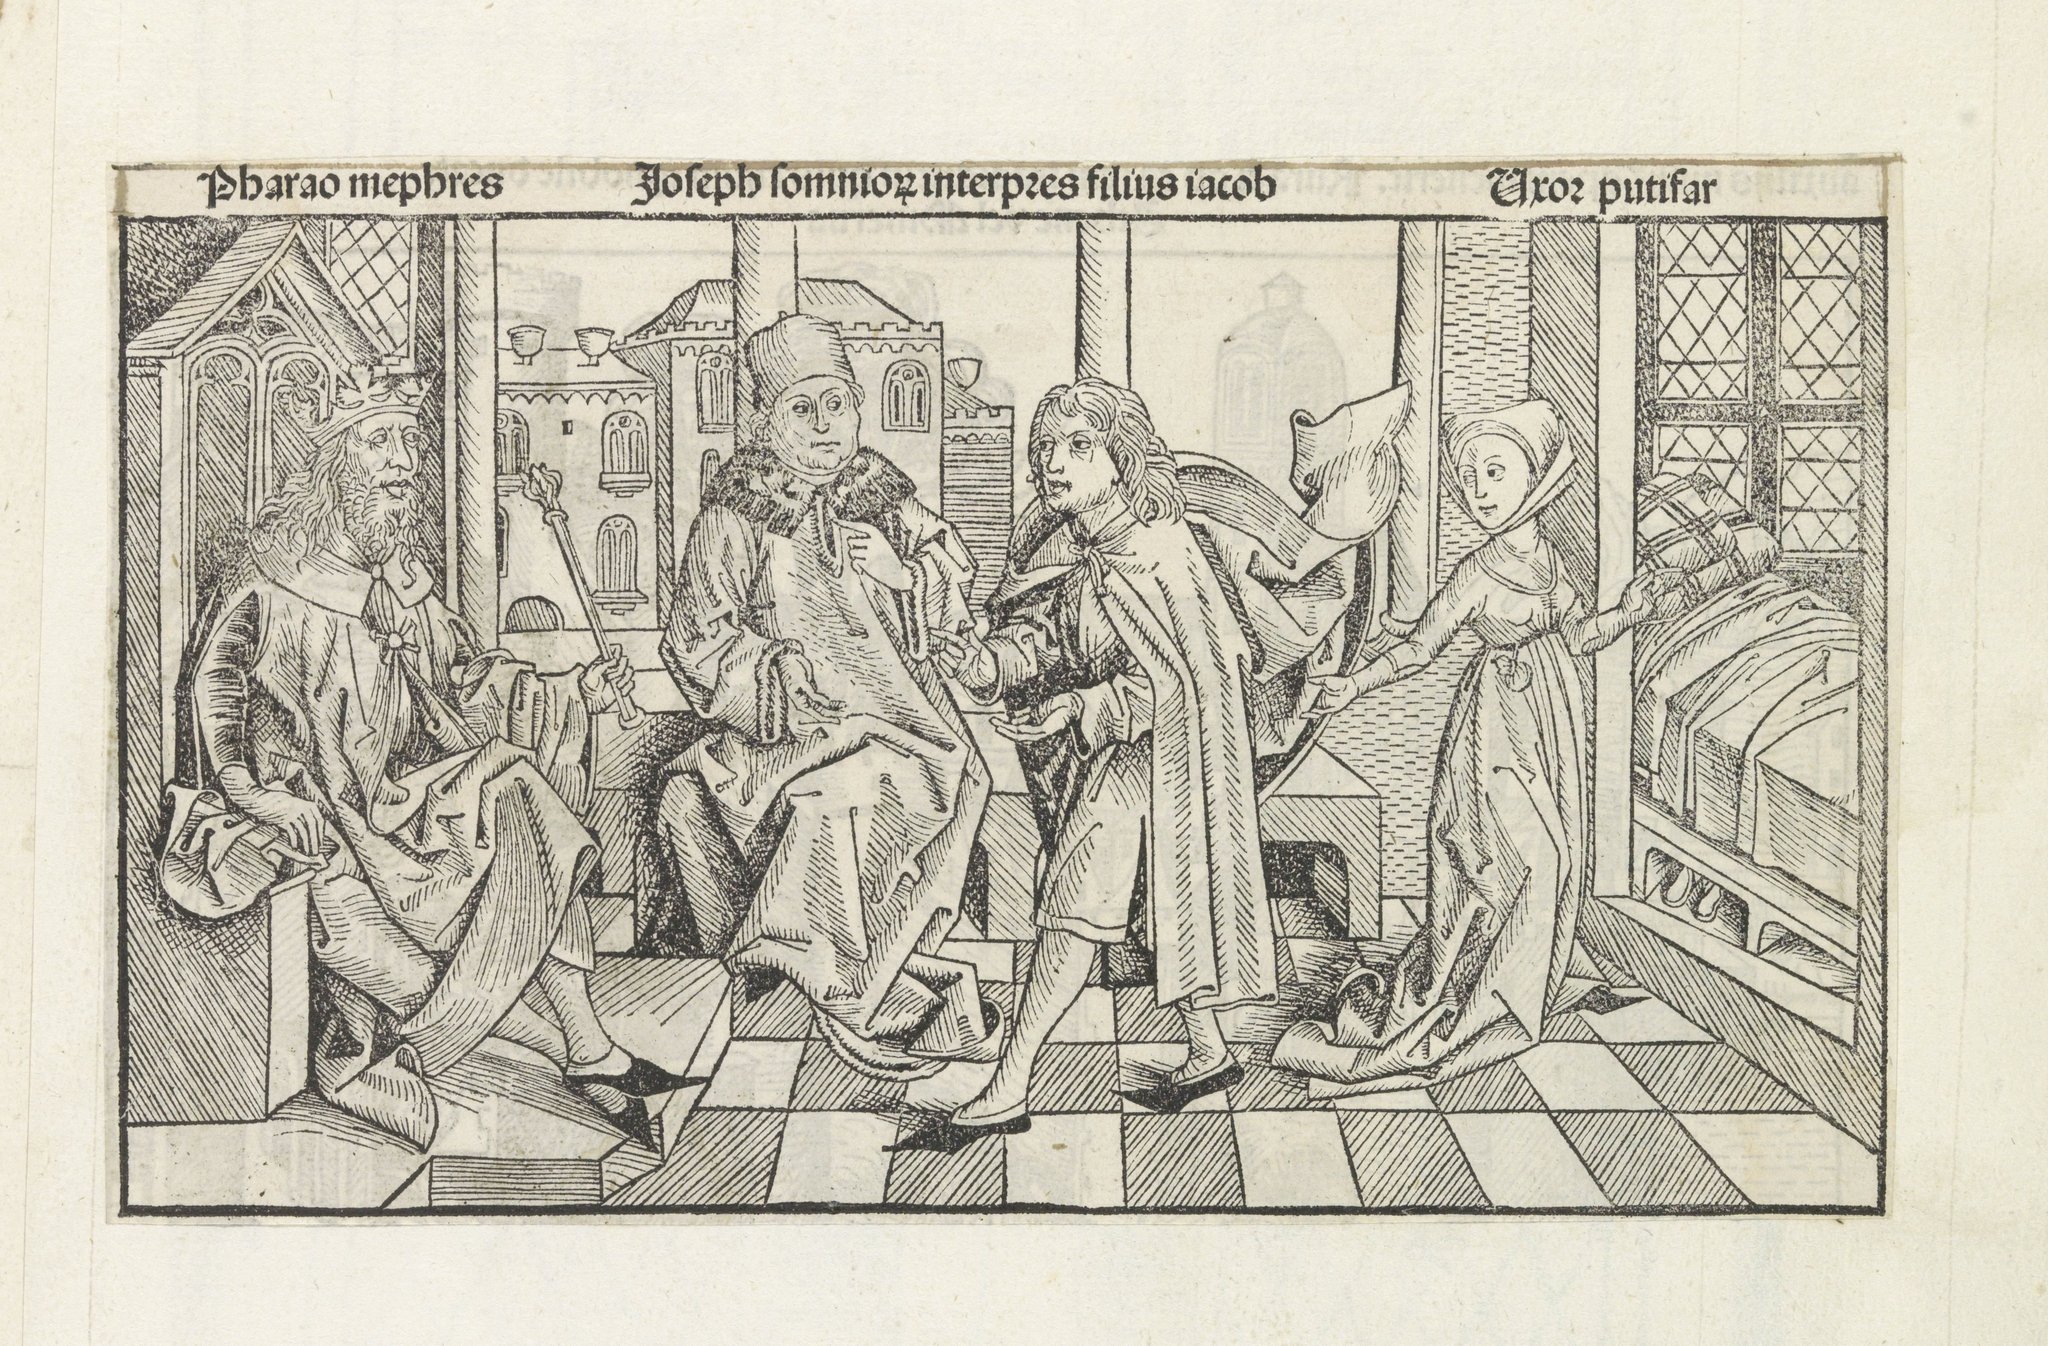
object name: album leaf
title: Jozef legt de dromen van de farao uit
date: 1493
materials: paper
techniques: letterpress printing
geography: nuremberg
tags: joseph interpreting pharaoh's dreams, potiphar's wife trying to seduce joseph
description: Jozef staat voor de farao, zittend op zijn troon, en legt hem zijn dromen uit. Rechts probeert Potifars vrouw Jozef te verleiden. Ze pakt hem bij zijn mantel en trekt hem naar haar bed. De prent maakt deel uit van een album.